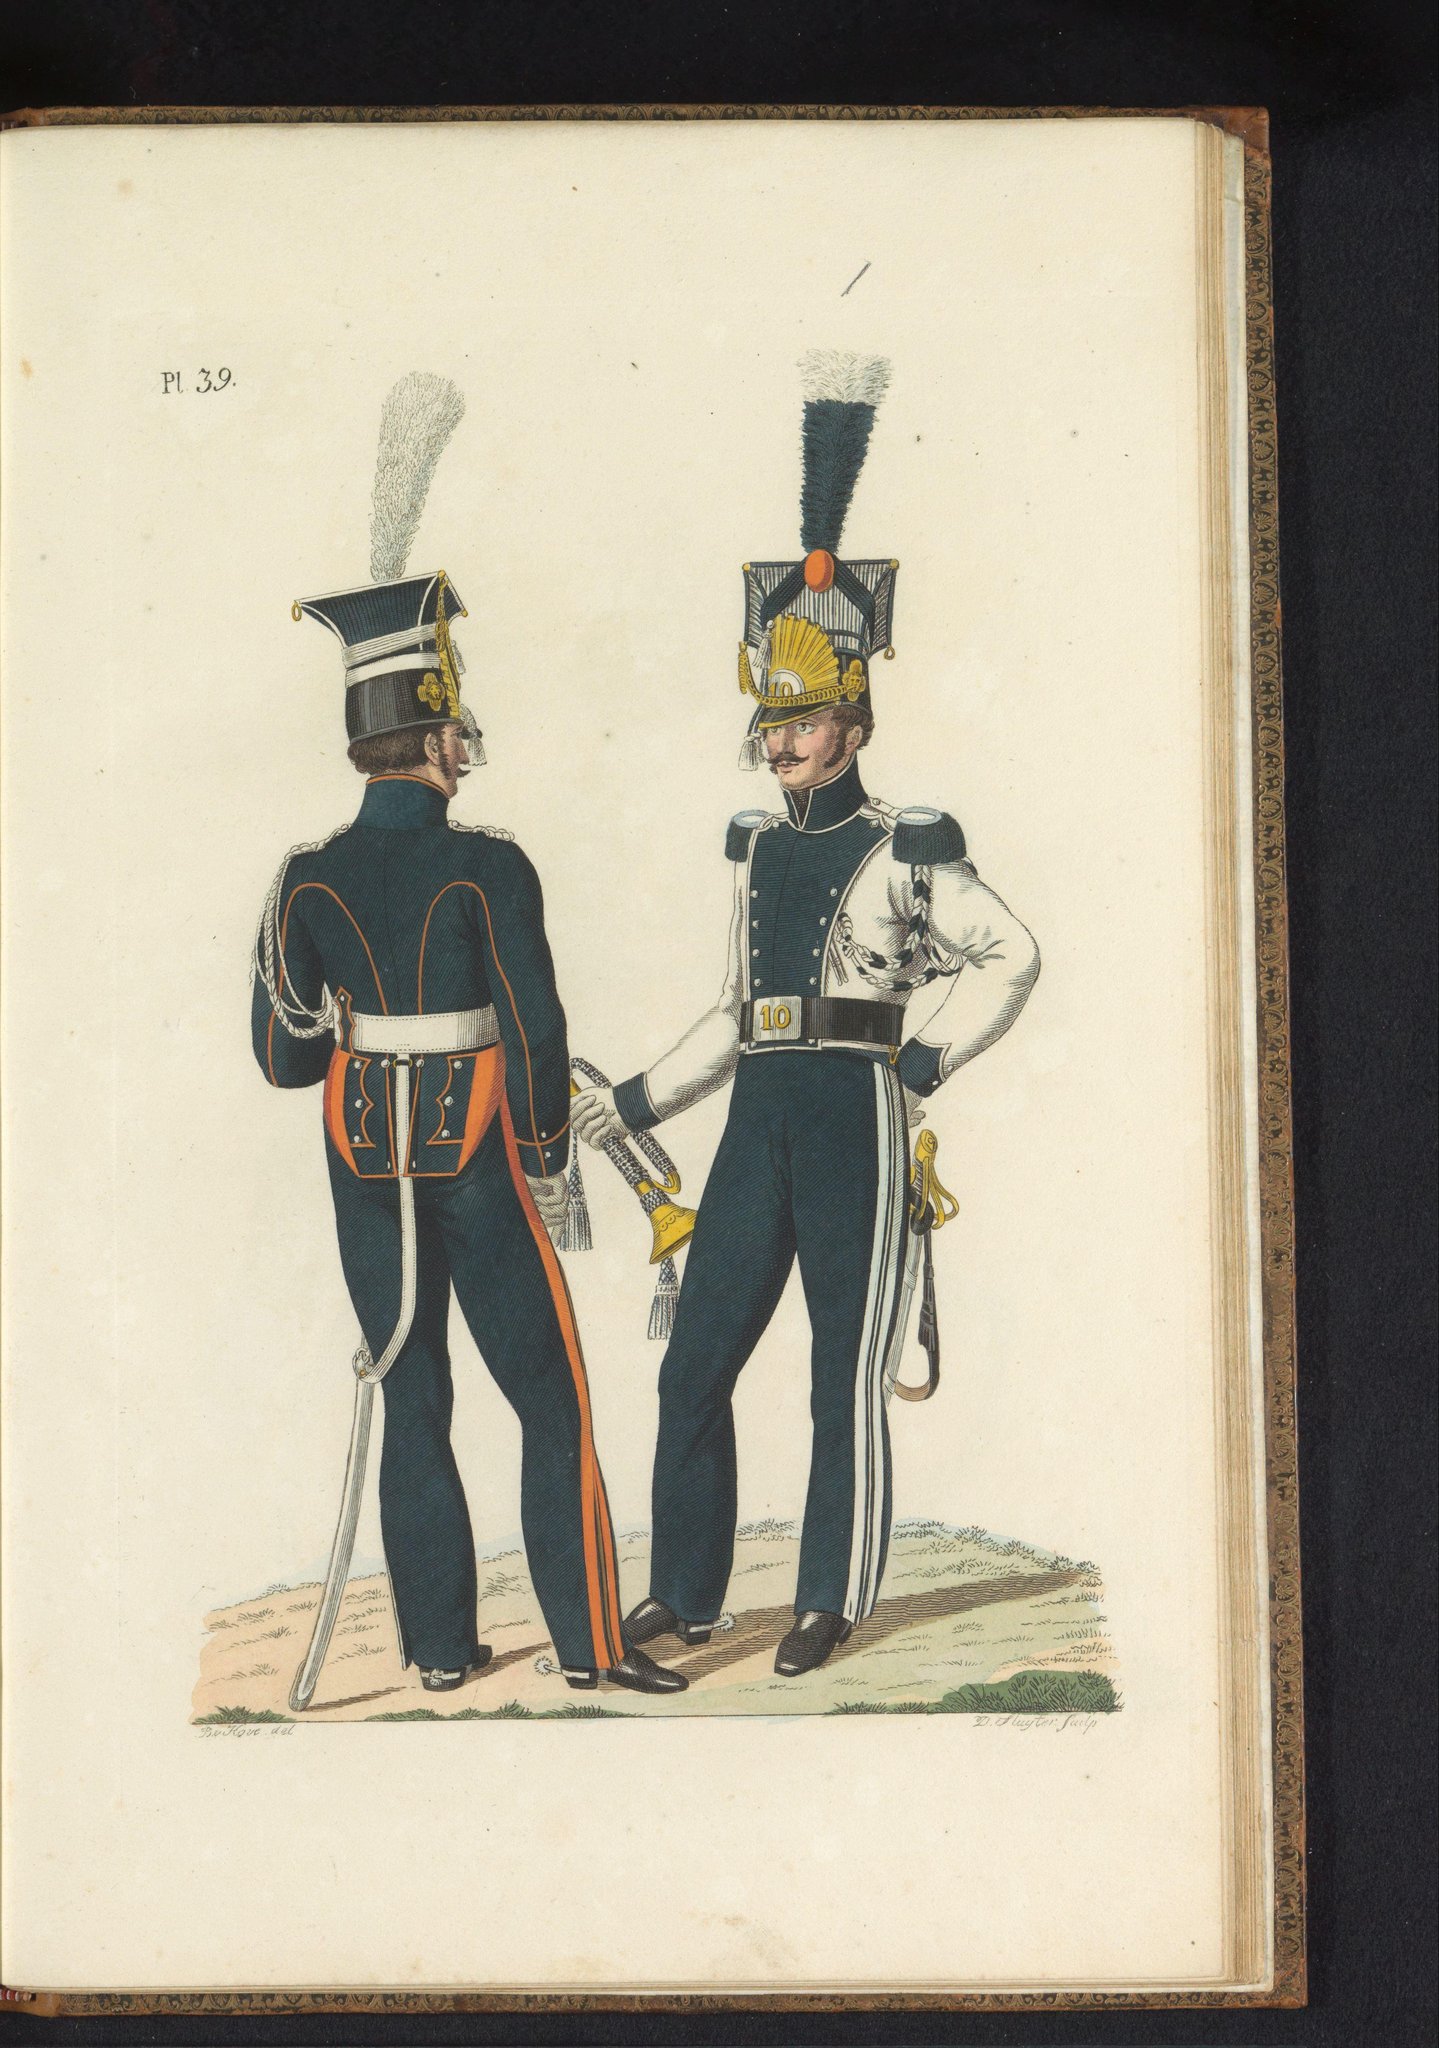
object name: print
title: Lancier en Trompetter, te voet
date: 1823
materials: paper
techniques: engraving, etching, hand coloring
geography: the hague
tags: (military) uniforms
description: Een Nederlandse lansier en een trompetter van het Regiment Lansiers Nr 10, te voet. Plaat 39. Uniformvoorstelling in 'Beschrijving hoedanig de Koninklijke Nederlandsche troepen' van J.F. Teupken, 1823.